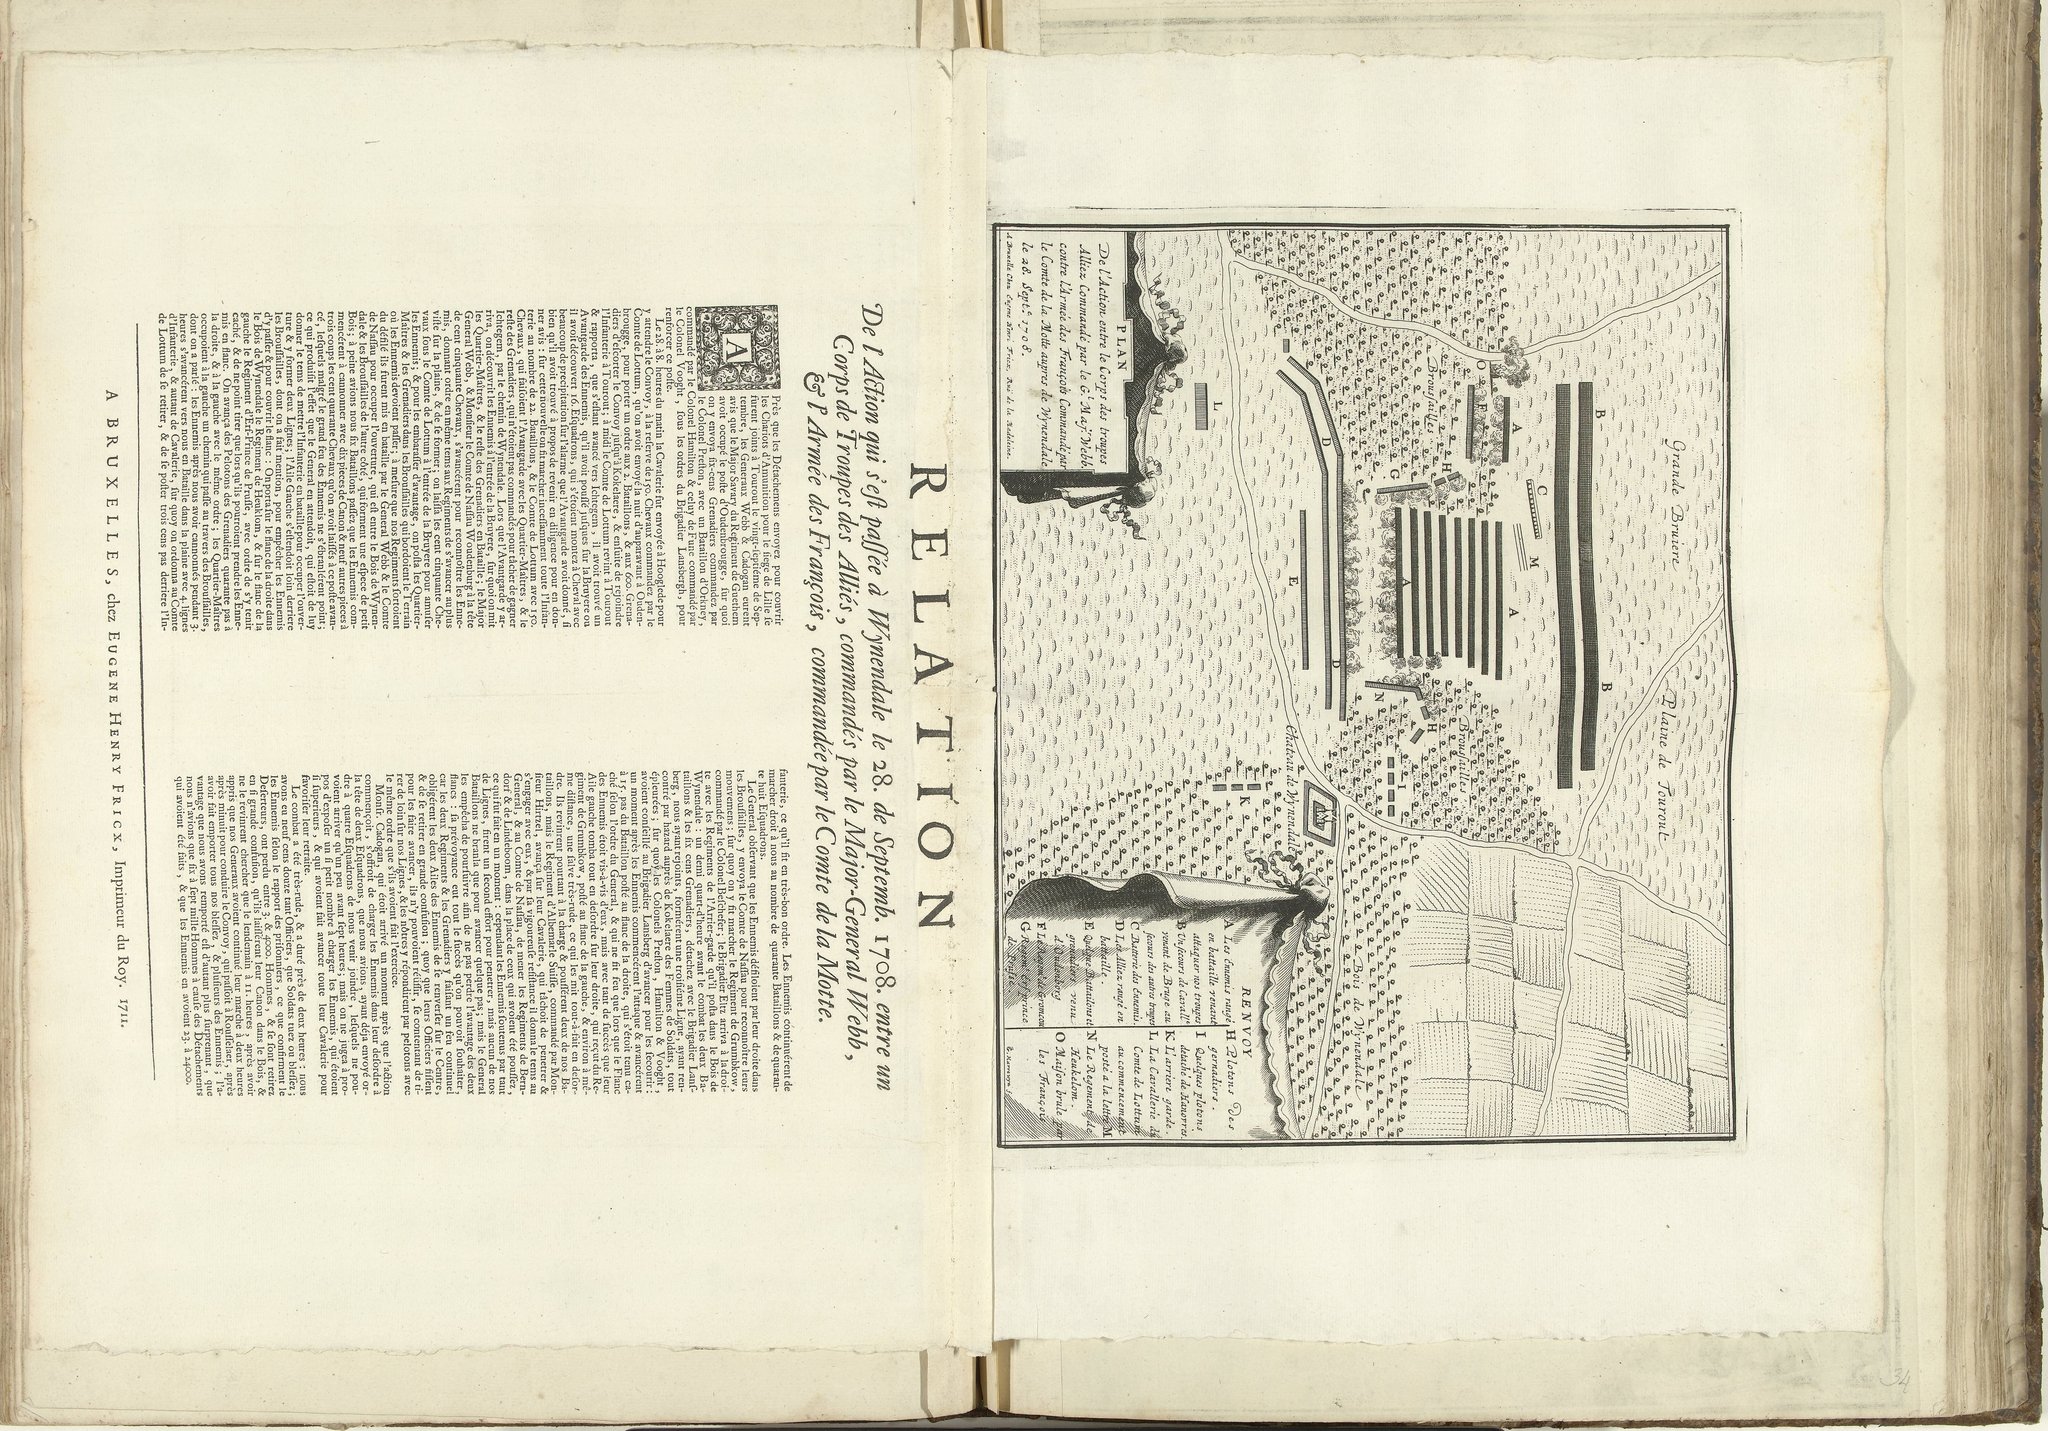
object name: print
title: Plan De l'Action entre le Corps des troupes Alliez Commandé par le Gl. Majr. Webb contre l'Armée des François Commandé par le Comte de la Motte aupres de Wynendale le 28. Septe. 1708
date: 1711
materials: paper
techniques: etching, letterpress printing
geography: brussels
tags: maps of separate countries or regions, battle (+ land forces)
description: Plattegrond van de slag op 28 september 1708 bij Wijnendale in West-Vlaanderen tussen de geallieerde troepen onder generaal-majoor Webb die een konvooi begeleidden en Franse troepen onder Graaf de la Mott. Rechtsonder een cartouche met de legenda A-O in het Frans. Vastgeplakt onder de prent een tekstblad met het gedrukte relaas in twee kolommen in het Frans. Onderdeel van een gebundelde verzameling van plannen van veldslagen en steden vermaard in de Spaanse Successieoorlog.